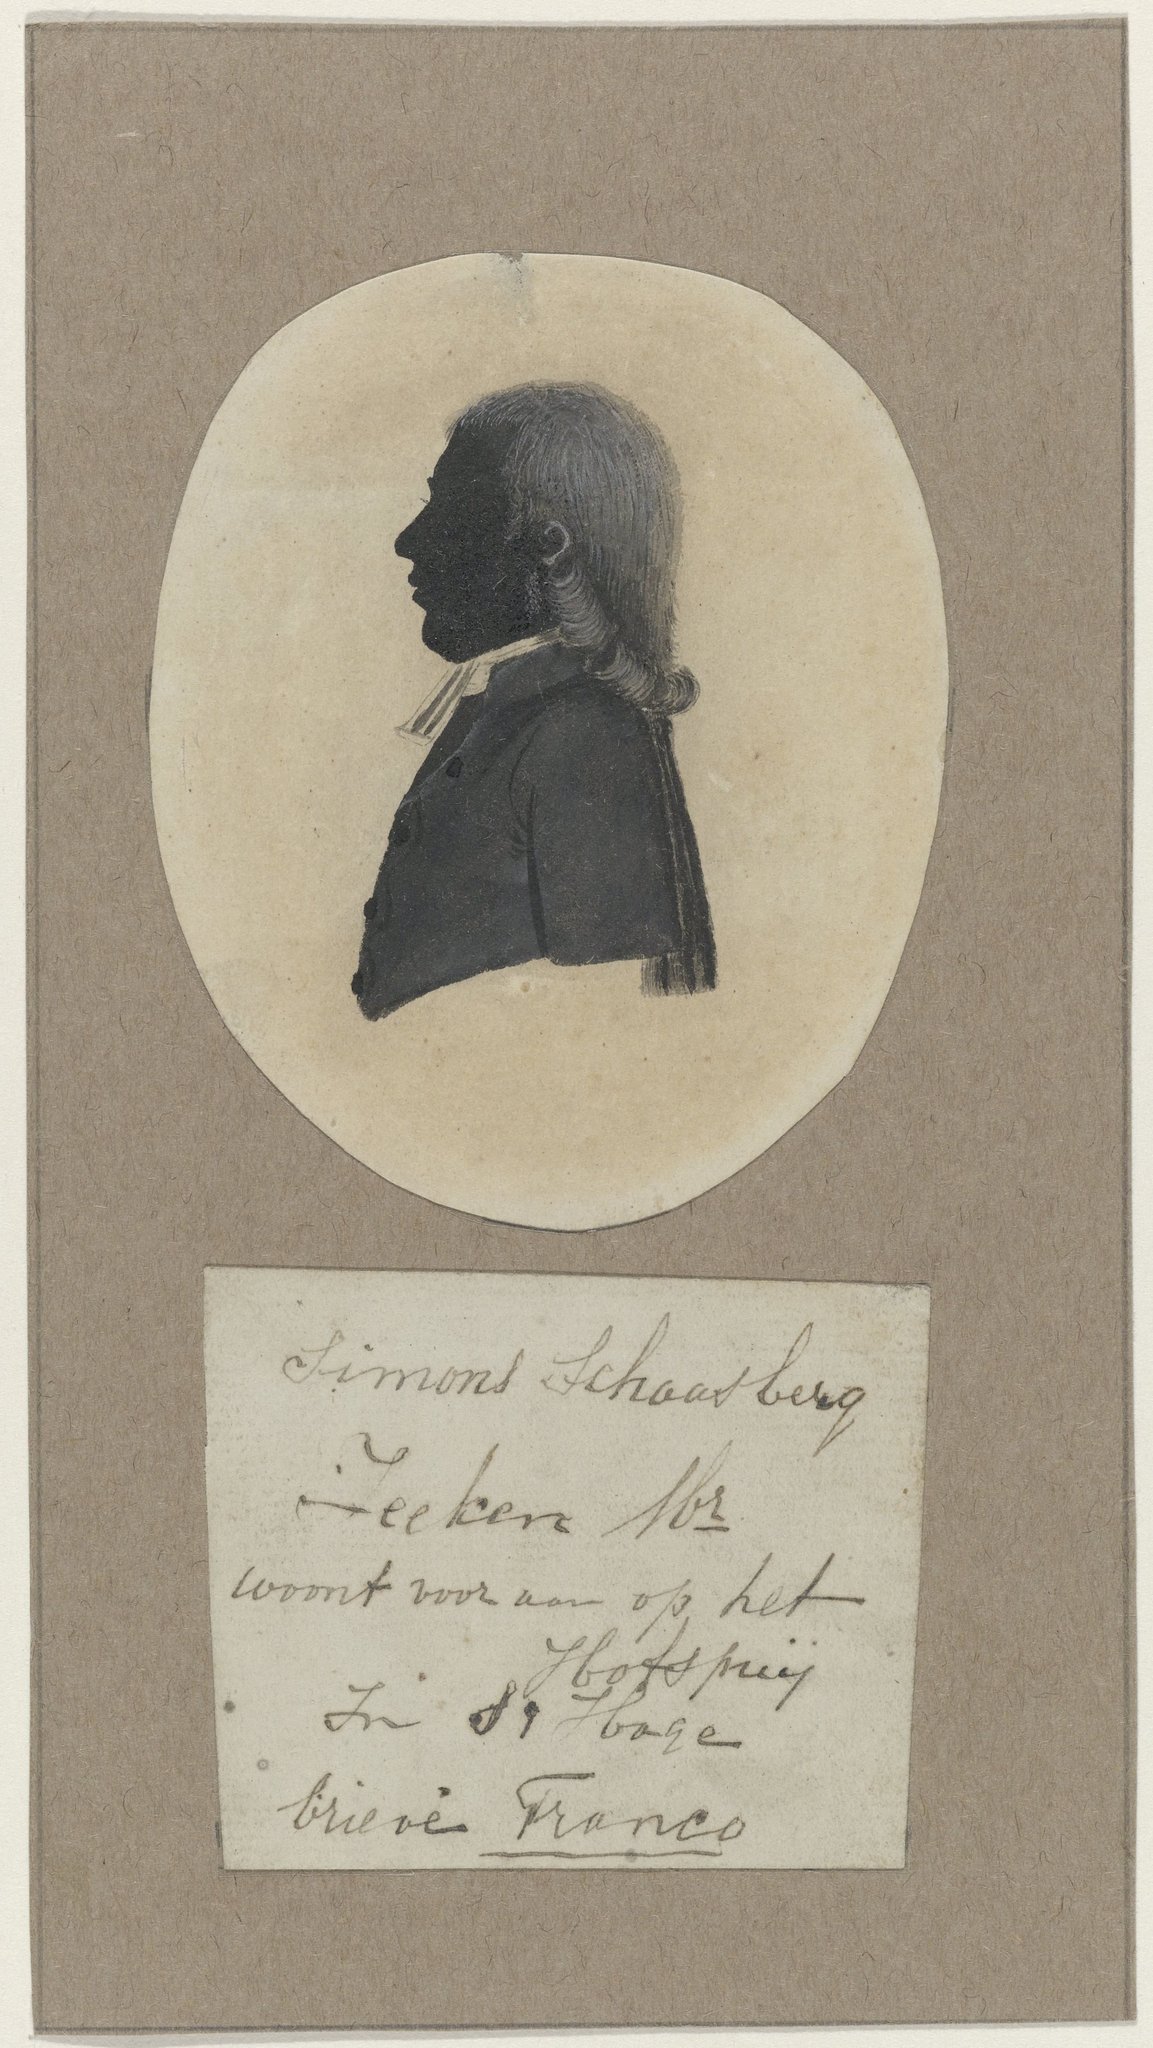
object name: drawing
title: Silhouet van een onbekende predikant, naar links kijkend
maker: simon schaasberg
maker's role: draughtsman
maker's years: 1753-1811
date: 1763-1811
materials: paper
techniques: brush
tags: anonymous historical person portrayed alone, male sex; man